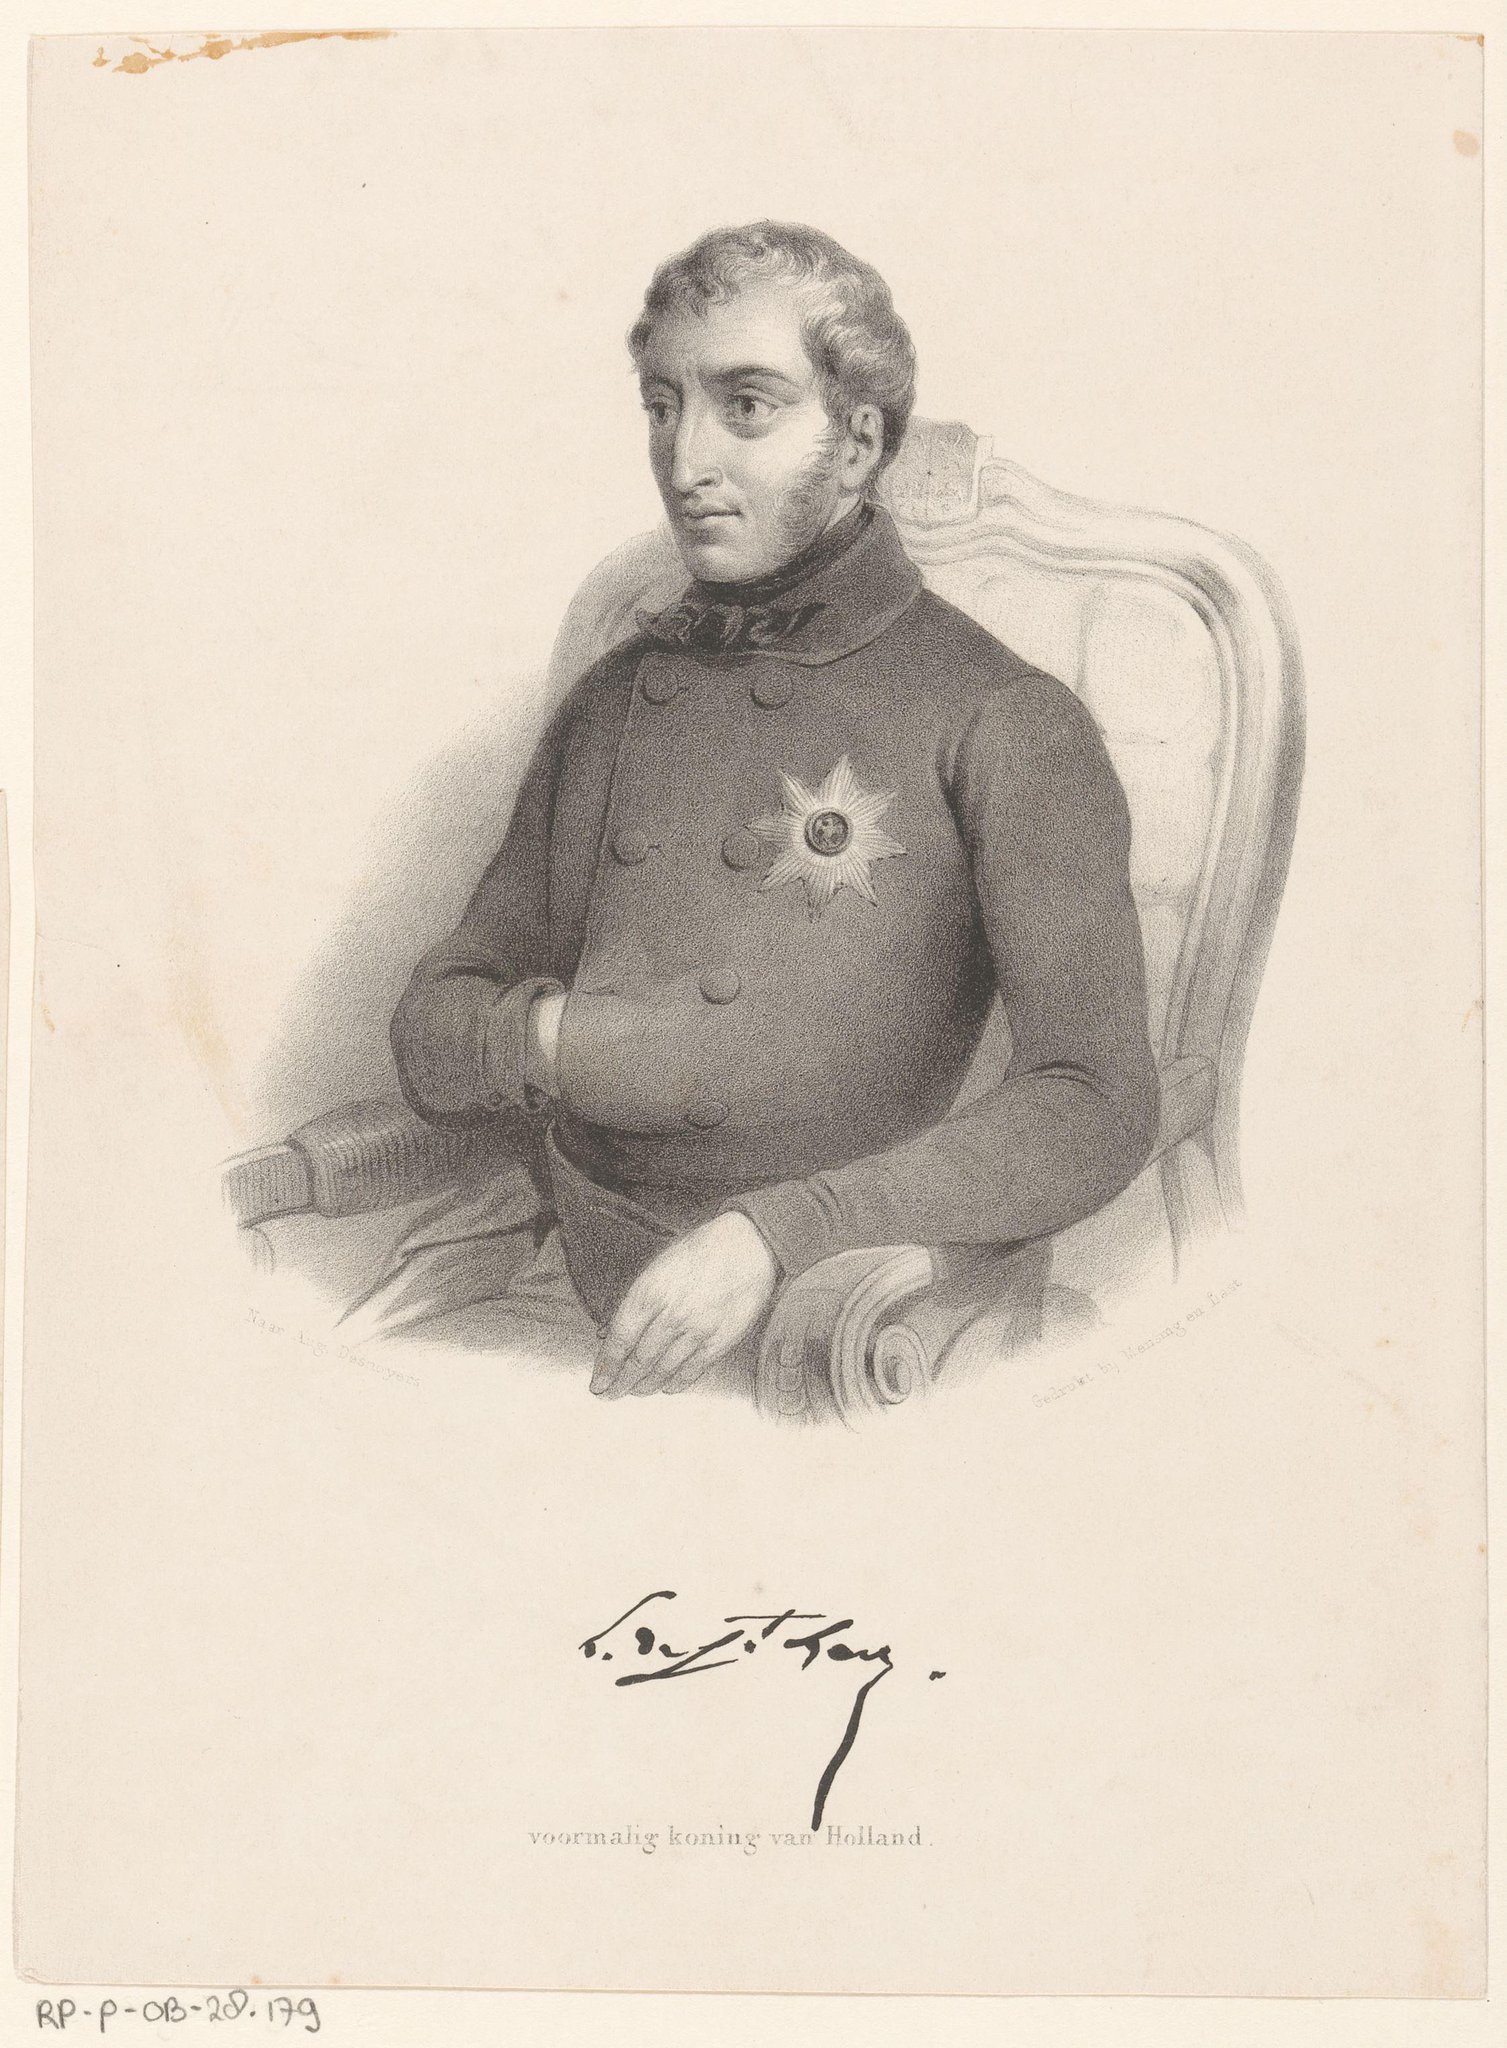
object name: print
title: Portret van een man, mogelijk Lodewijk Napoleon Bonaparte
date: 1841-1847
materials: paper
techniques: lithograph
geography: the hague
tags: knighthood order, historical persons (+ half-length portrait)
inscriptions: collector's mark: Lugt 2228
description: De geportretteerde zit in een stoel en heeft zijn rechterhand in zijn jas gestoken. Op zijn borst draagt hij de Orde van de Zwarte Adelaar. Onder het portret zijn signatuur.